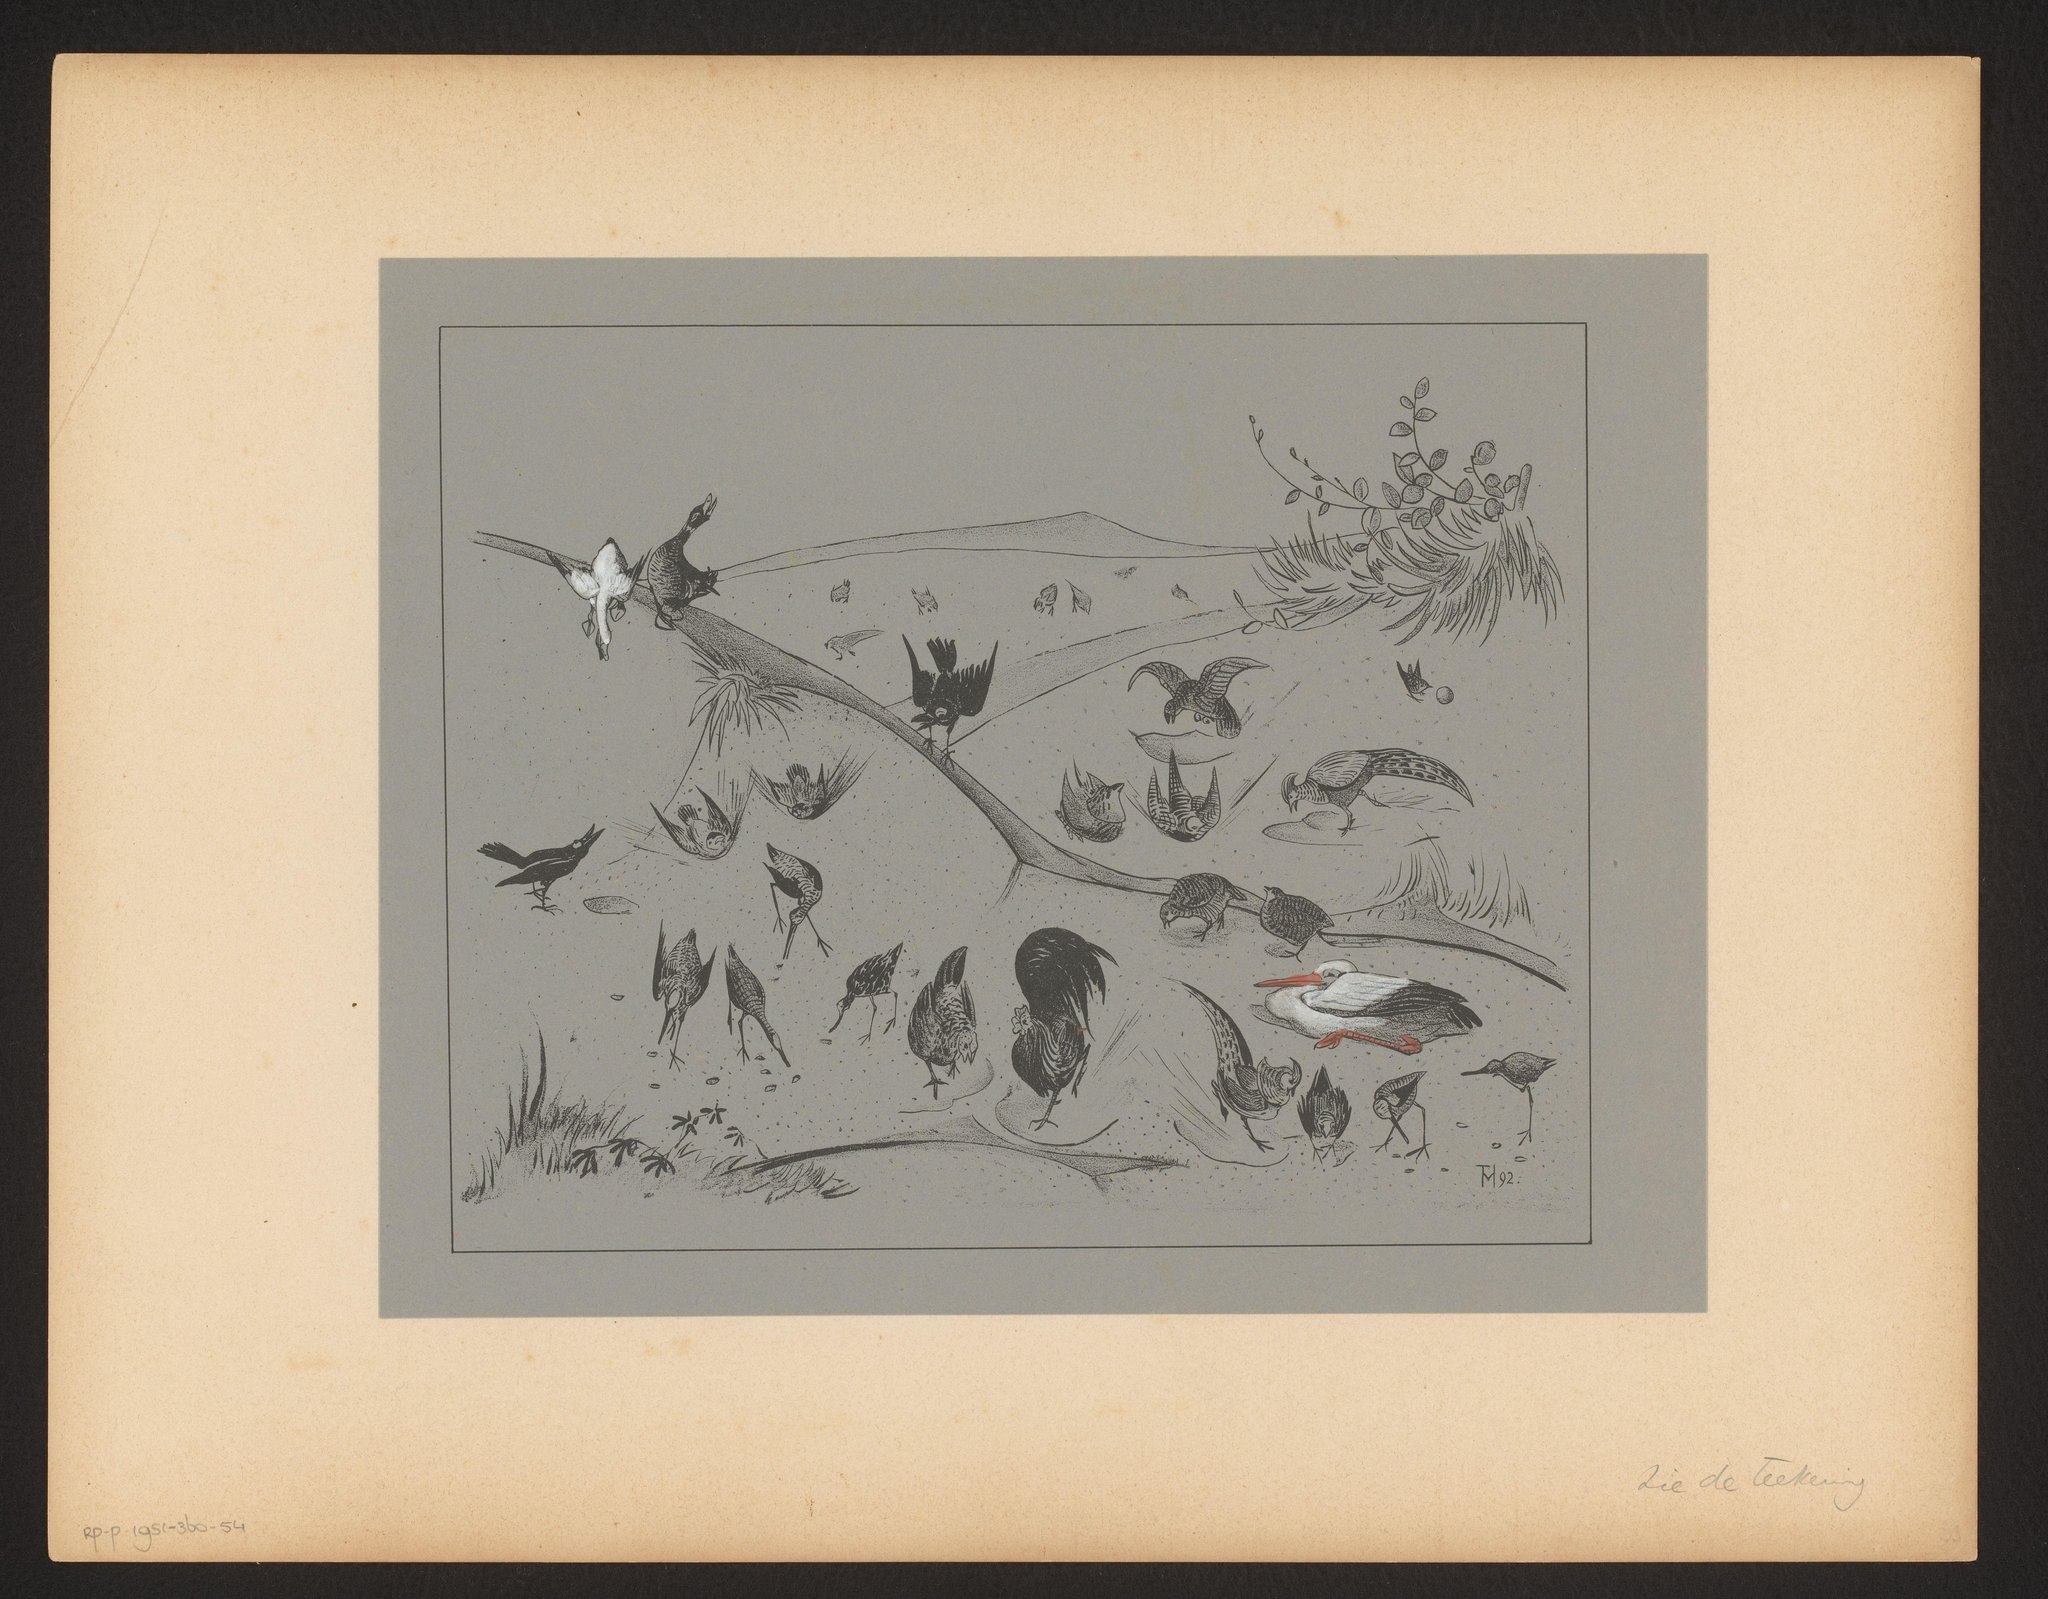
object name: print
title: Hoe de vogels aan een koning kwamen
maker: theo van hoytema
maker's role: draughtsman, painter, print maker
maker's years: 1863-1917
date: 1892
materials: paper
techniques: hand coloring, lithograph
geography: the hague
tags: groups of birds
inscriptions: date